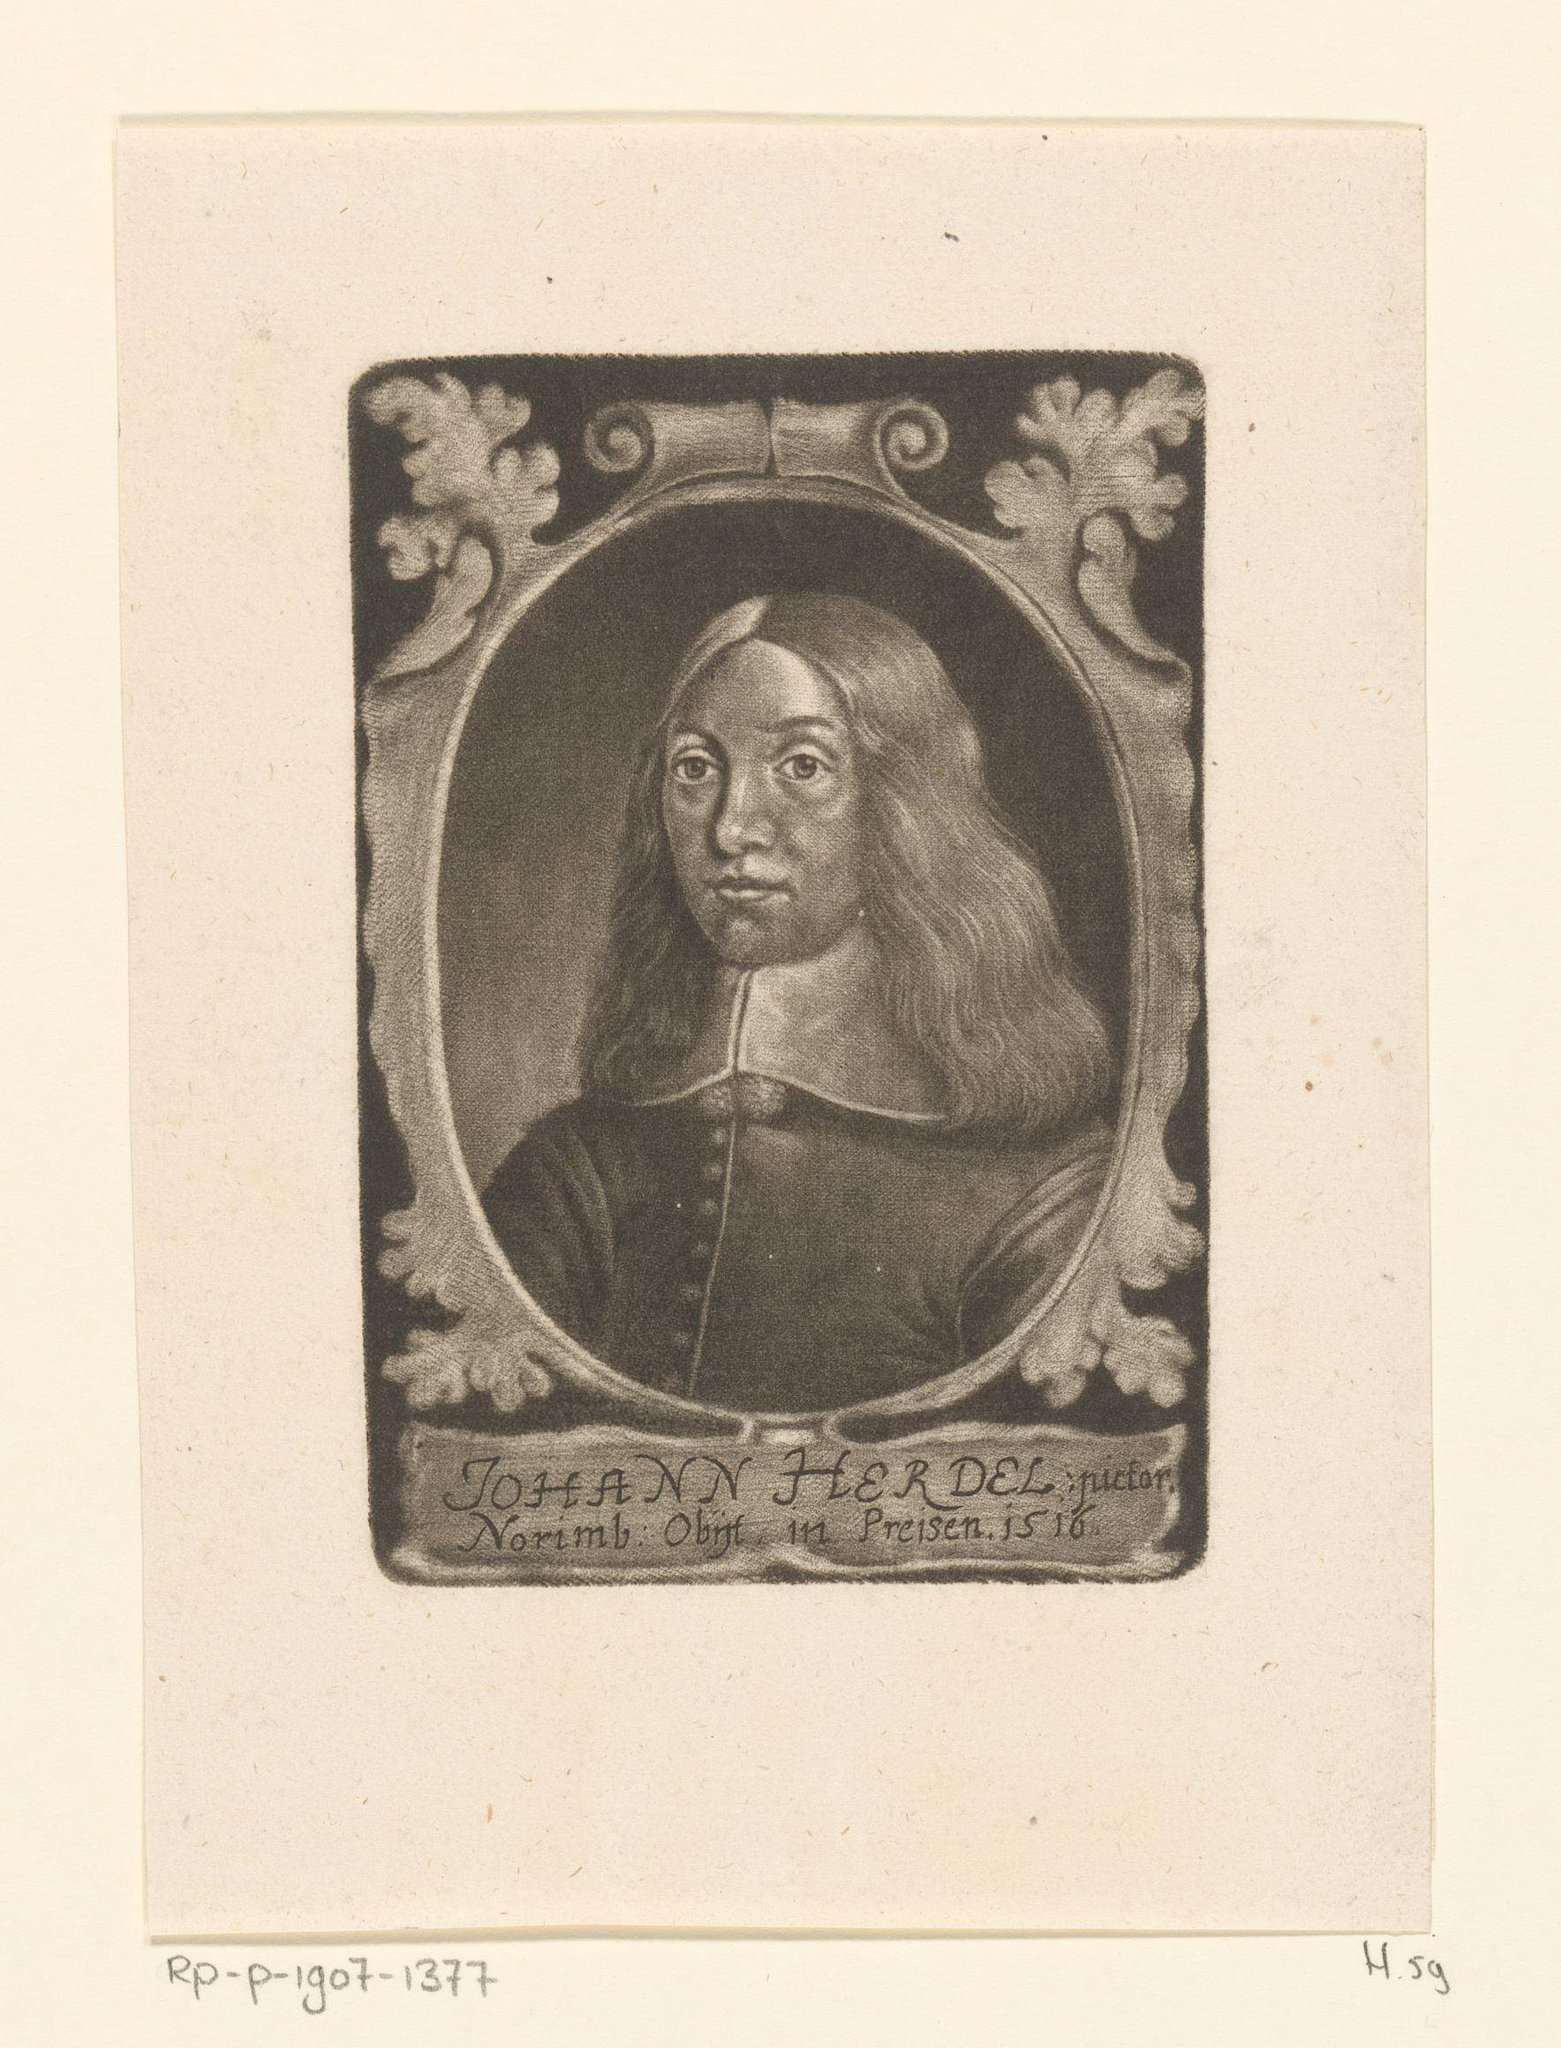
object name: print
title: Portret van Johann Herdel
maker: georg fennitzer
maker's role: print maker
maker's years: 1646-1722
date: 1656-1722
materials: paper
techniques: mezzotint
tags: painter, historical persons, ornament ~ cartouche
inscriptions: collector's mark: Lugt 2228